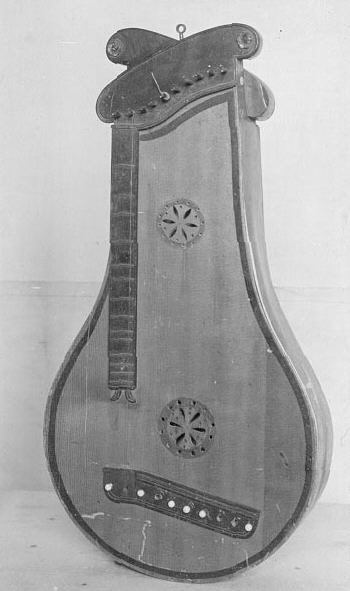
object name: double zither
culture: german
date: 1801-1900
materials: metal, wood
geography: germany